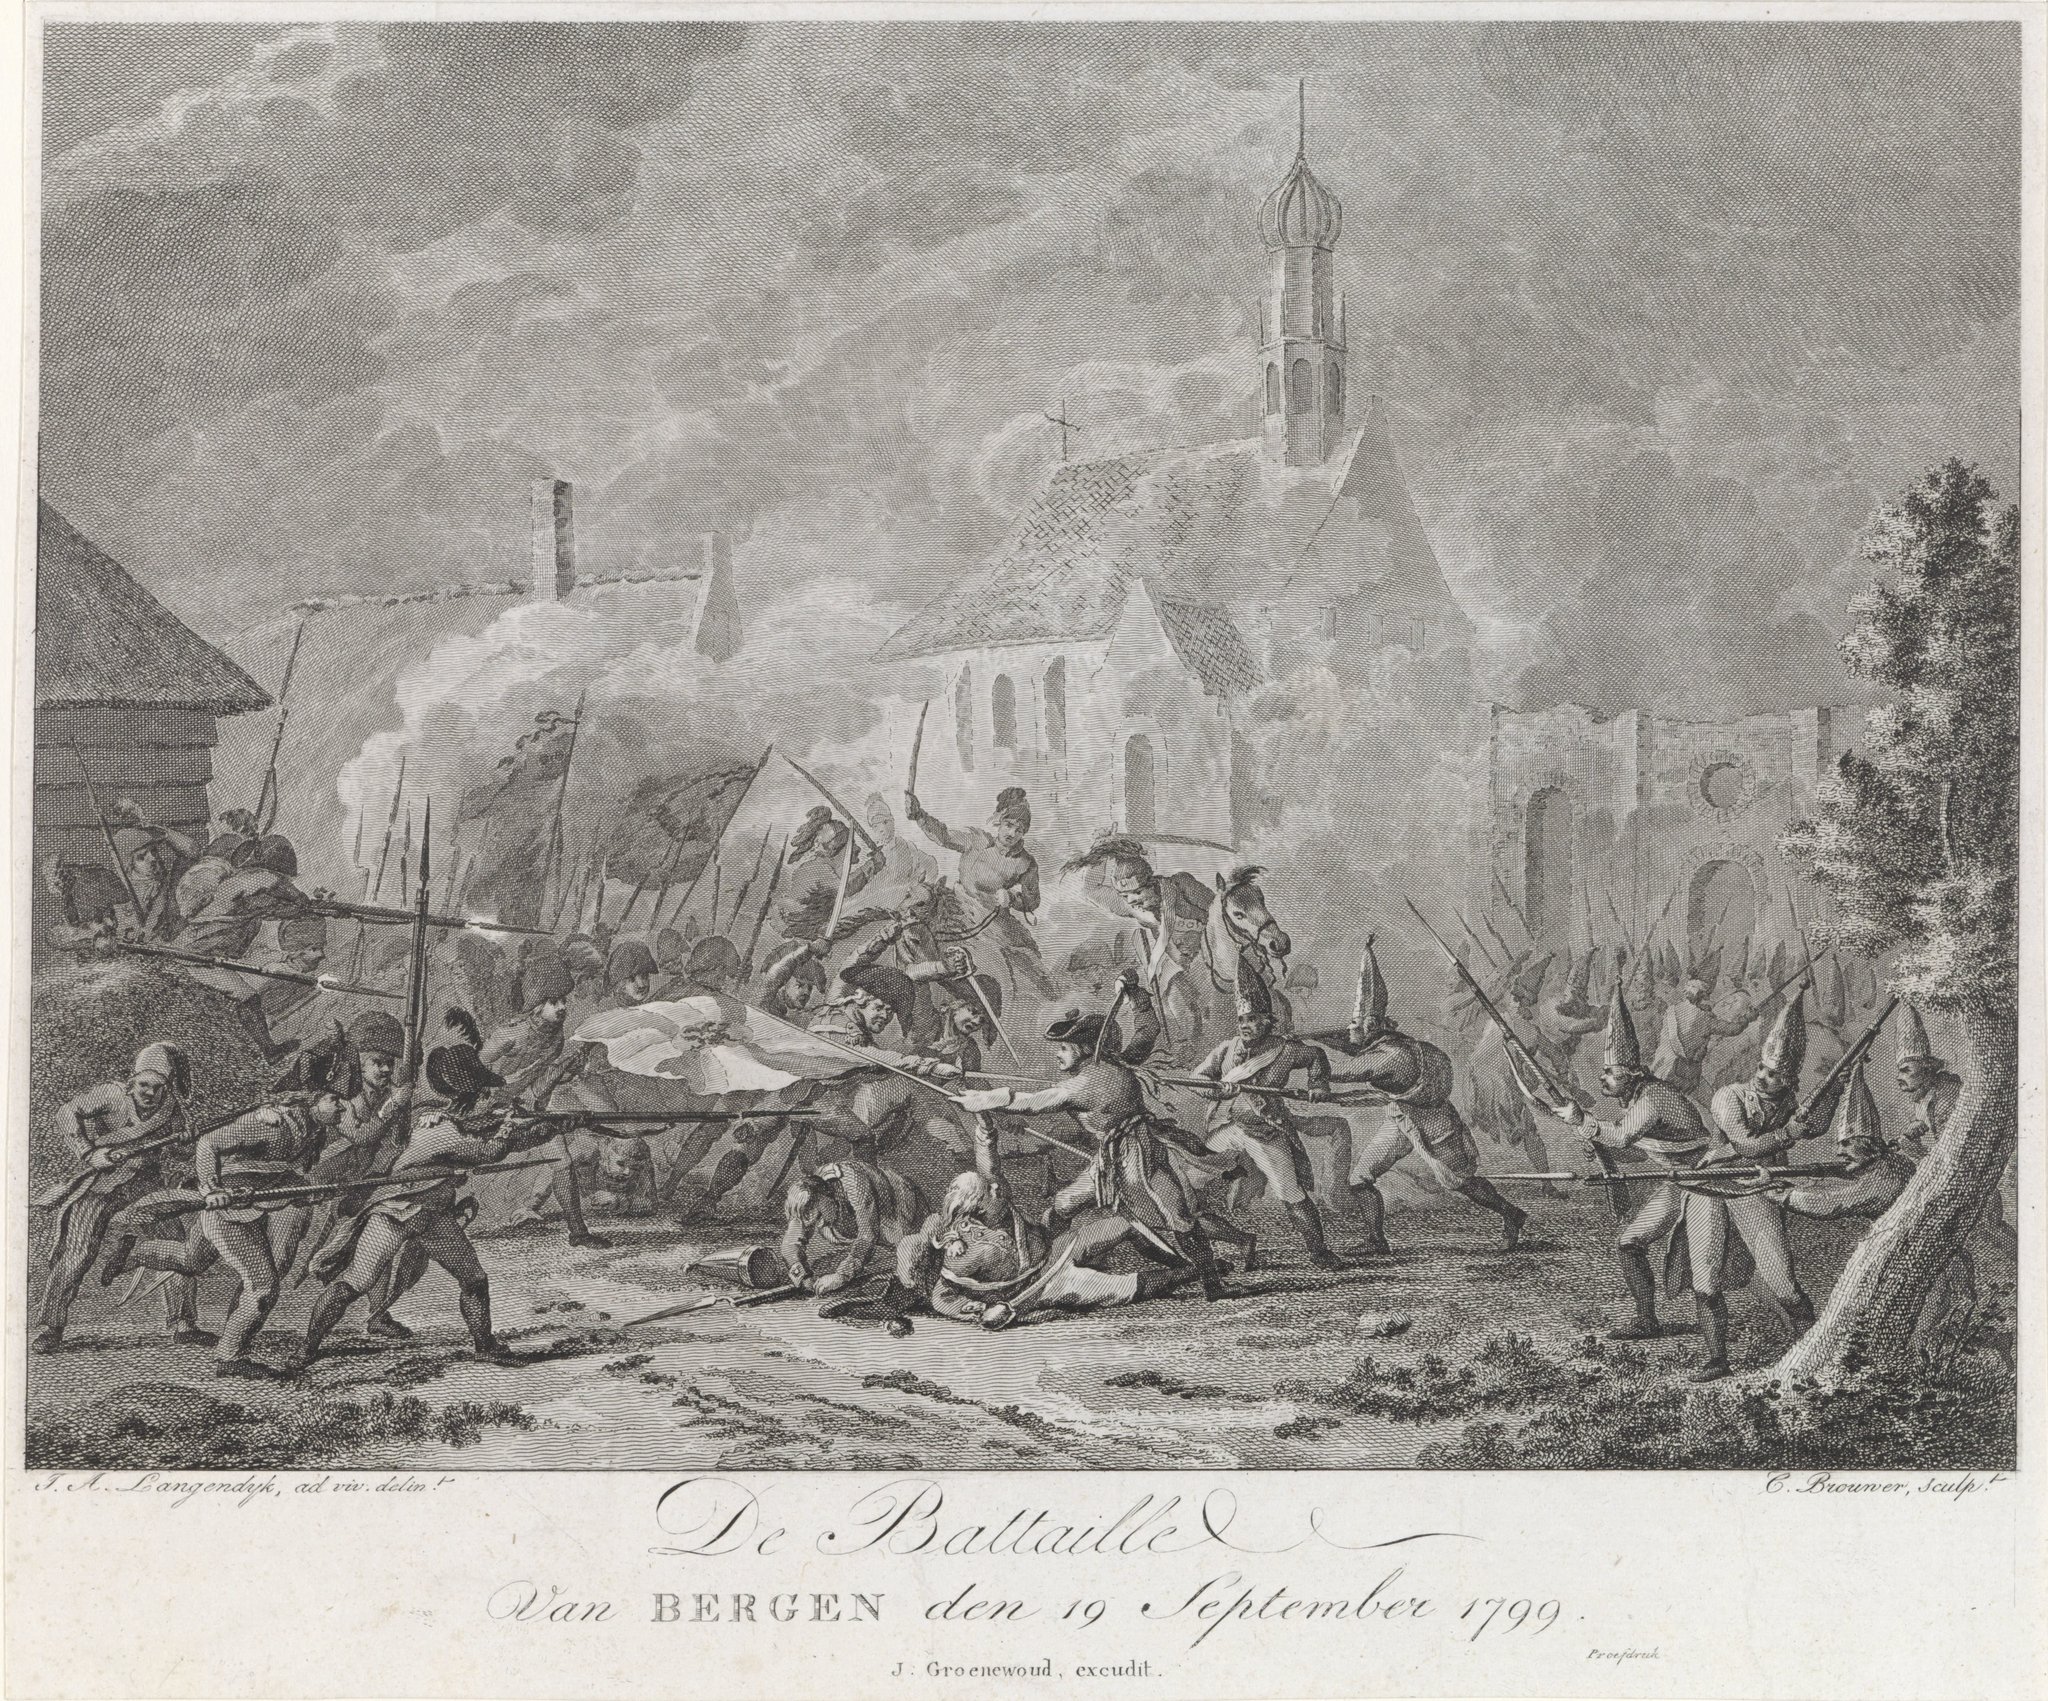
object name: print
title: Slag bij Bergen, 1799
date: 1800-1802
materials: paper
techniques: engraving, etching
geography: netherlands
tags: battle (+ land forces)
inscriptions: collector's mark: Lugt 2228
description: Slag bij Bergen op 19 september 1799 waarij het Frans-Bataafse leger een overwinning behaalde op de Brits-Russische invasiemacht. Voor een kerk wordt woest van man op man gevochten.